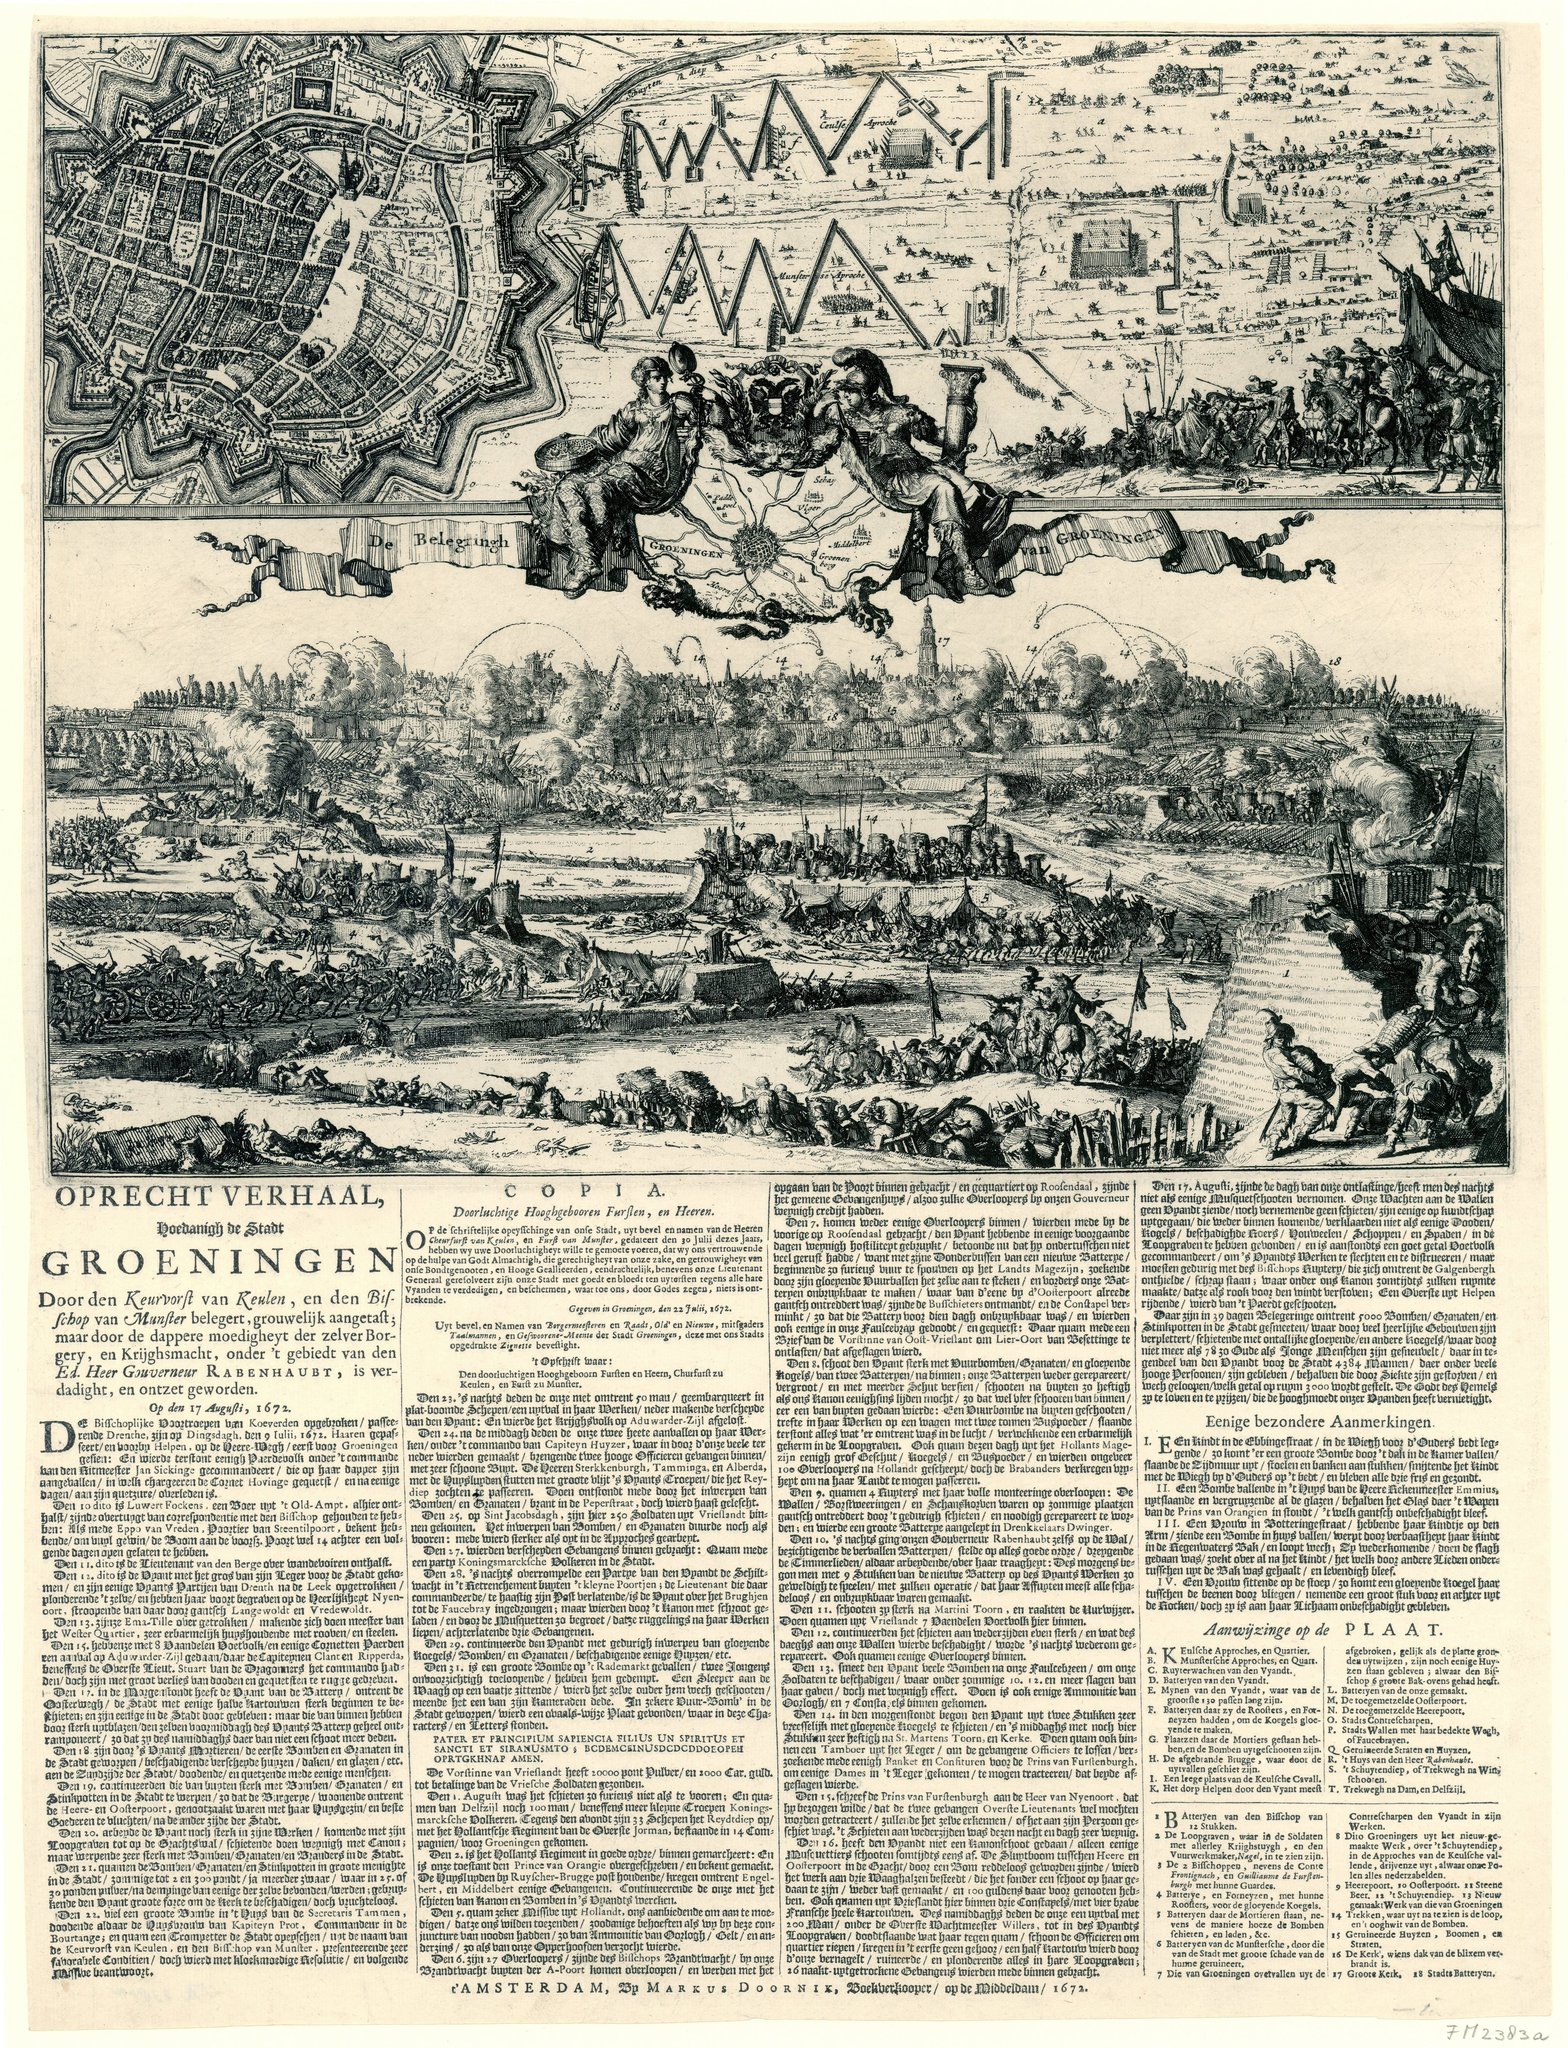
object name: print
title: Oprecht Verhaal, Hoedanigh de Stadt Groeningen Door den Keurvorst van Keulen, en den Bisschop van Munster belegert, grouwelijk aangetast; maar door de dappere moedigheyt der zelver Borgery, en Krijghsmacht, onder 't gebiedt van den Ed. Heer Gouverneur Rabenhaubt, is verdadight, en ontzet geworden. Op den 17 Augusti, 1672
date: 1672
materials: paper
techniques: etching, letterpress printing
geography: amsterdam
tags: maximiliaan hendrik van beieren, raising the siege with outside assistance, relief, siege, position war, maps of cities, rampjaar (disaster year)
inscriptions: date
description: Blad met verschillende voorstellingen van het beleg van Groningen tussen juli en augustus 1672. Boven een plattegrond van de stad met de posities van de belegerende troepen. In het midden een kaartje van de stad en directe omgeving op een leeuwenhuid geflankeerd door de personificaties van Voorzichtigheid en Kracht. Hieronder een gezicht op de stad Groningen die onder vuur wordt genomen. Onder de voorstellingen een tekst over vier kolommen met een beschrijving van de gebeurtenissen en de legenda's A-T en 1-17.